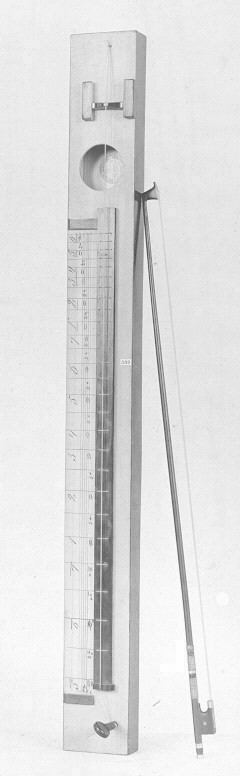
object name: psalmodikon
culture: norwegian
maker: w. harloff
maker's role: maker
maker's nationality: norwegian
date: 1801-1900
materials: metal, wood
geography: norway